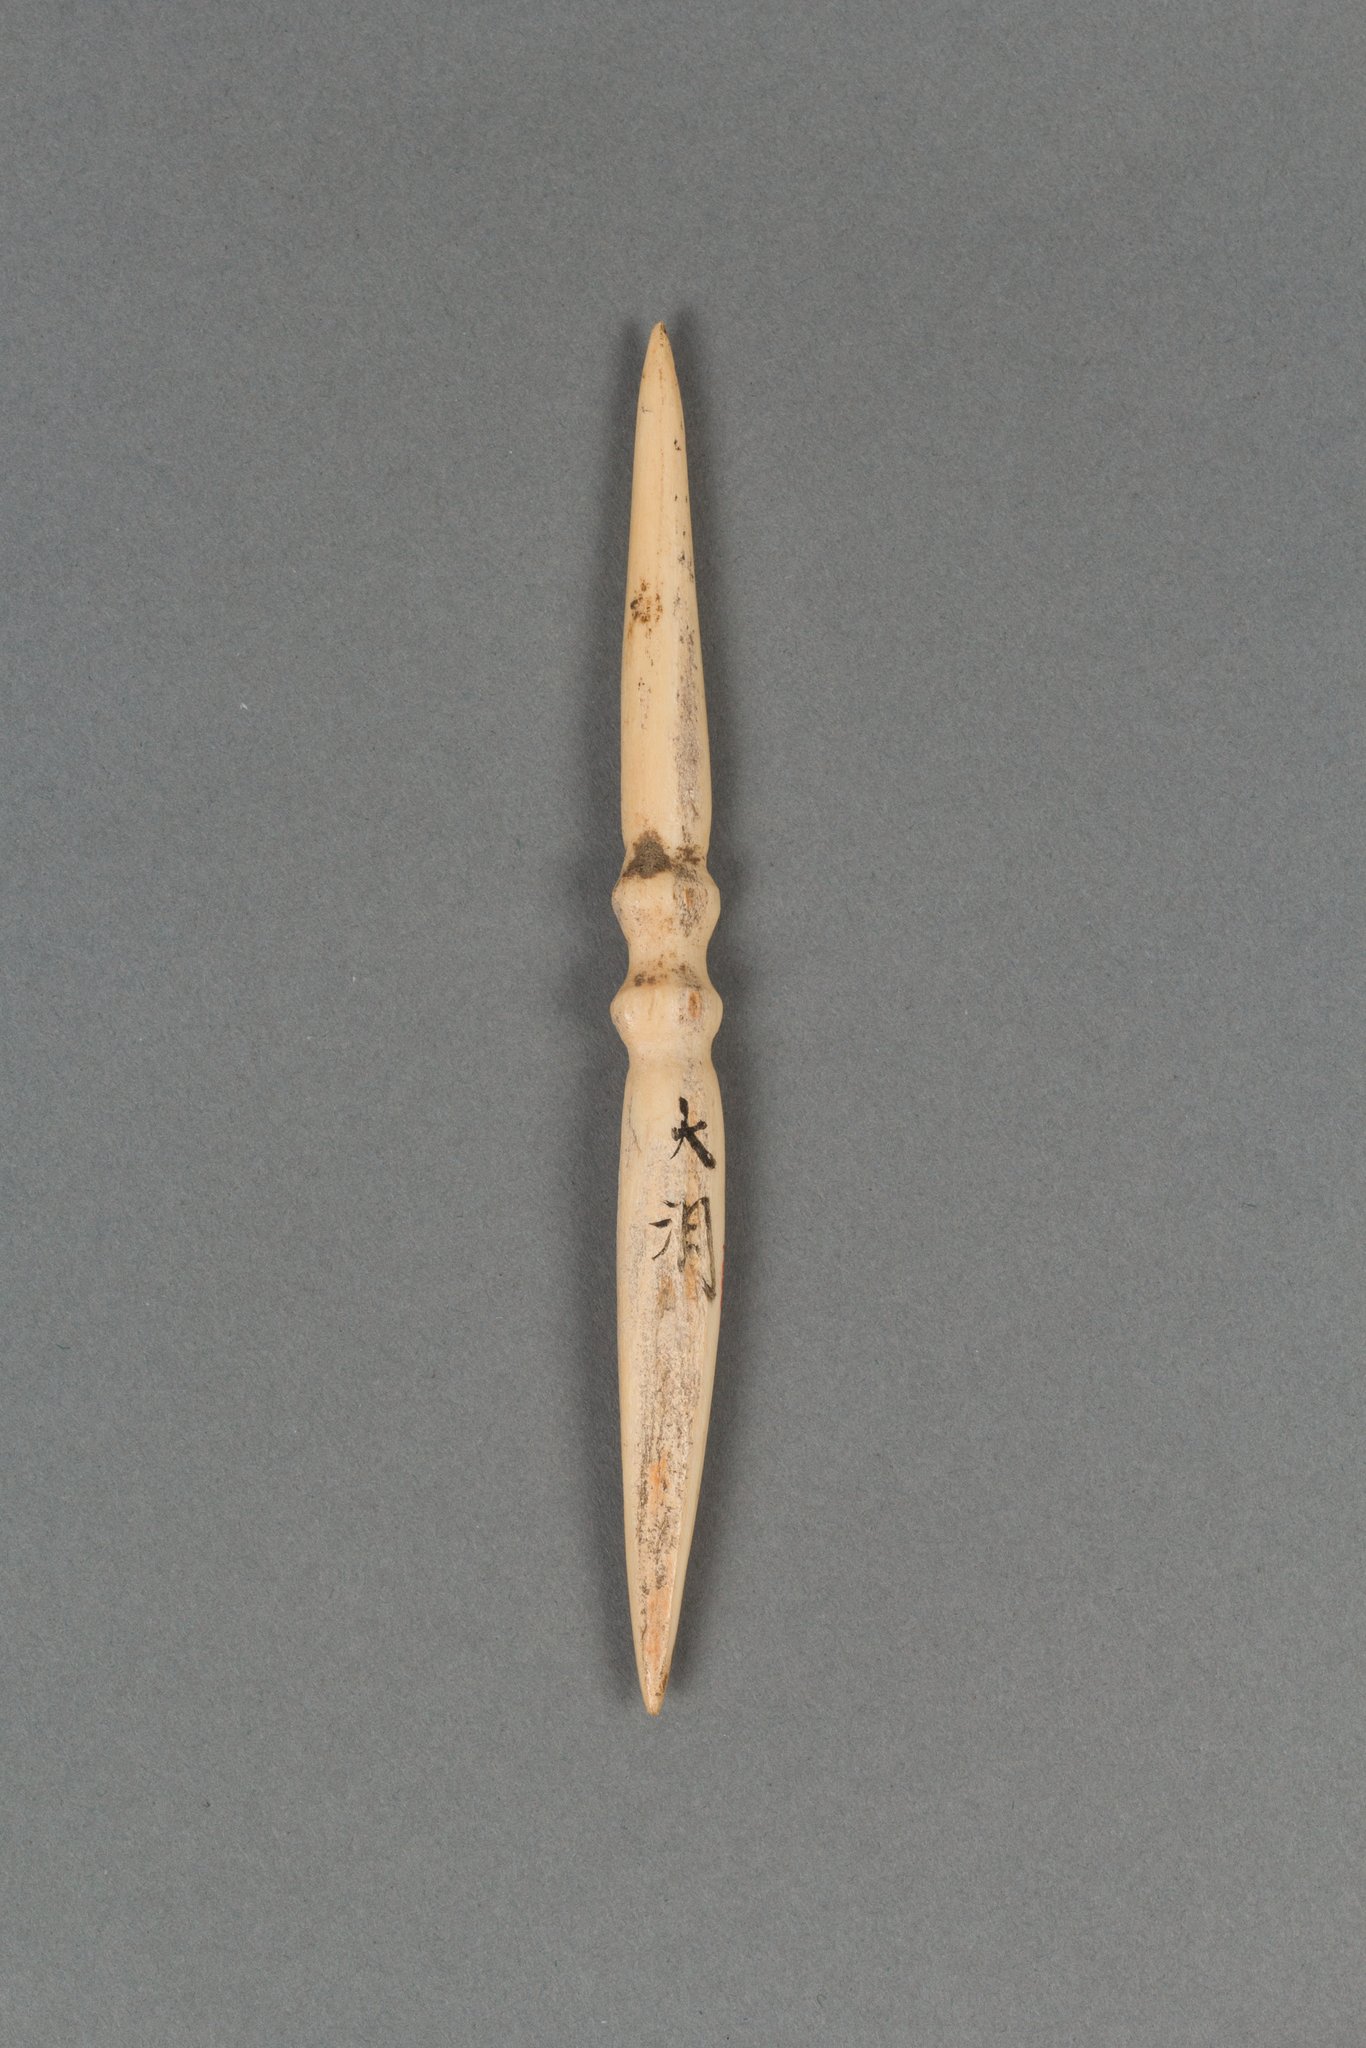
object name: body ornament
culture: japanese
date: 1200-200 BCE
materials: bone